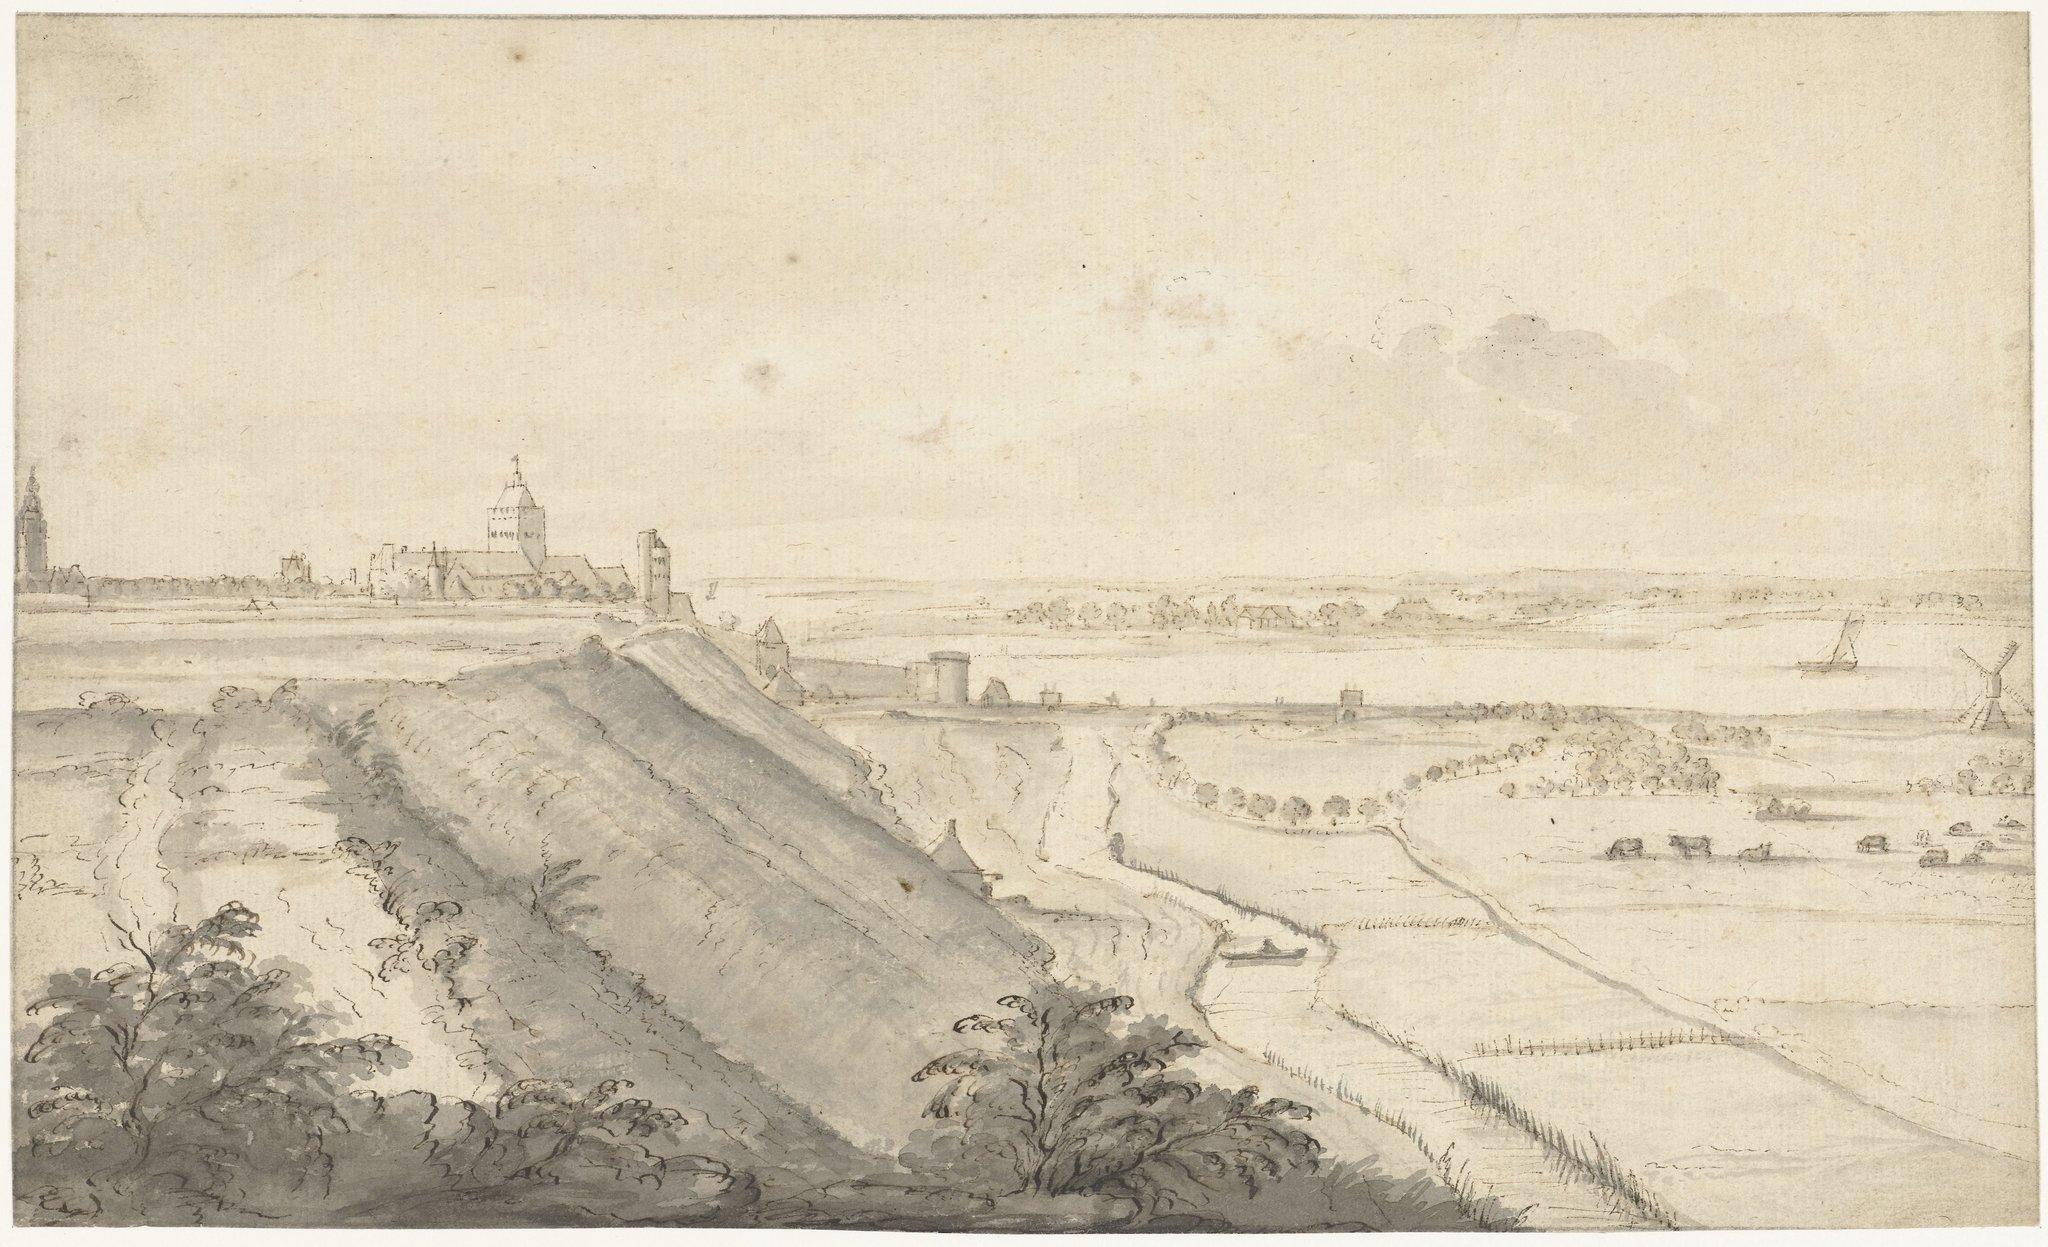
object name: drawing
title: Gezicht op Nijmegen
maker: jacob van eynden (i)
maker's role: draughtsman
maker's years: 1696-1775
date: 1710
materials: ink, paper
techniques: brush, pen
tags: prospect of city, town panorama, silhouette of city, nijmegen